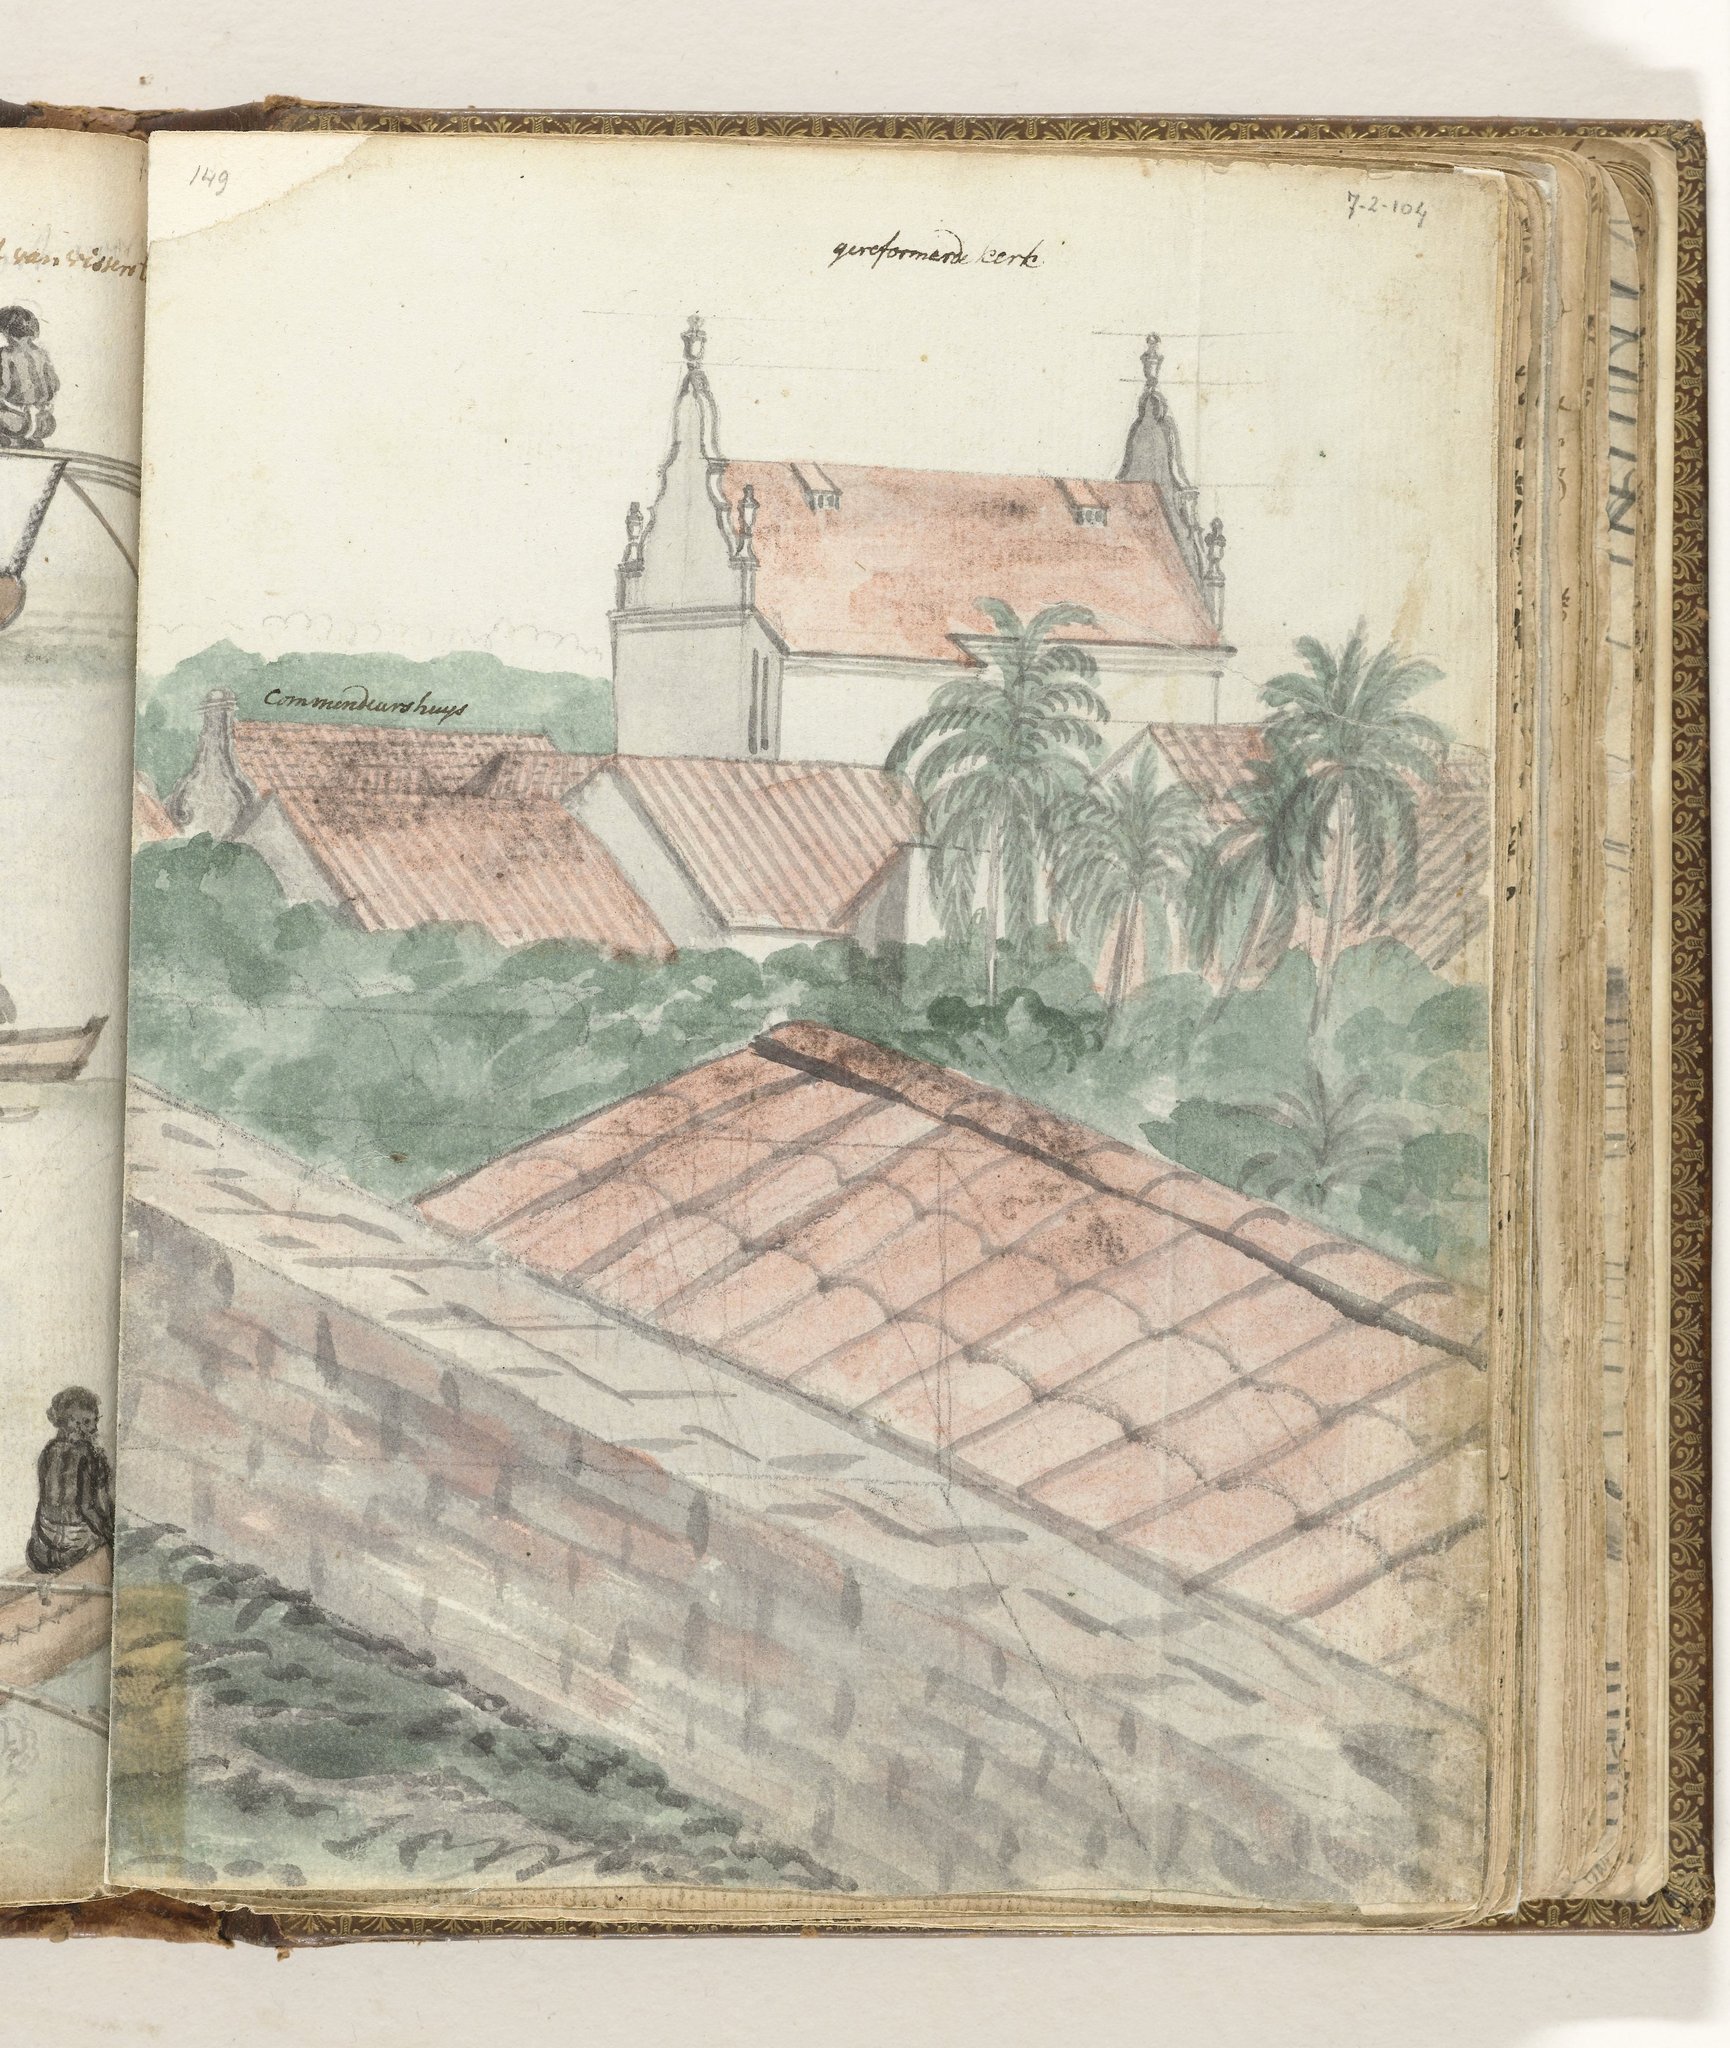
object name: drawing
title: View over Galle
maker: jan brandes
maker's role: draughtsman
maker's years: 1743-1808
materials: paper, pencil, watercolor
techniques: brush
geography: galle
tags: city-view in general; 'veduta'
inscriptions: inscription: ‘De stad Gale op Ceylon’, inscription: ‘vlaggestoksstraat daar ik logeerde by Hr Otto / dit is de muur van de vlagge stok / gereformeerde kerk / de hoogberg / s'Compagnies Pakhuis / adams berg’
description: Kleurtekening over drie pagina's van de stad Galle op Ceylon met het commandeurshuis, de gereformeerde kerk, het Compagnie's pakhuis en in het verschiet de Adamsberg. Met opschrift. Onderdeel uit het schetsboek van Jan Brandes, dl. 2 (1808), p. 148-150, 175. (Rechts van p. 150 hoort in deel 2, p. 175.)